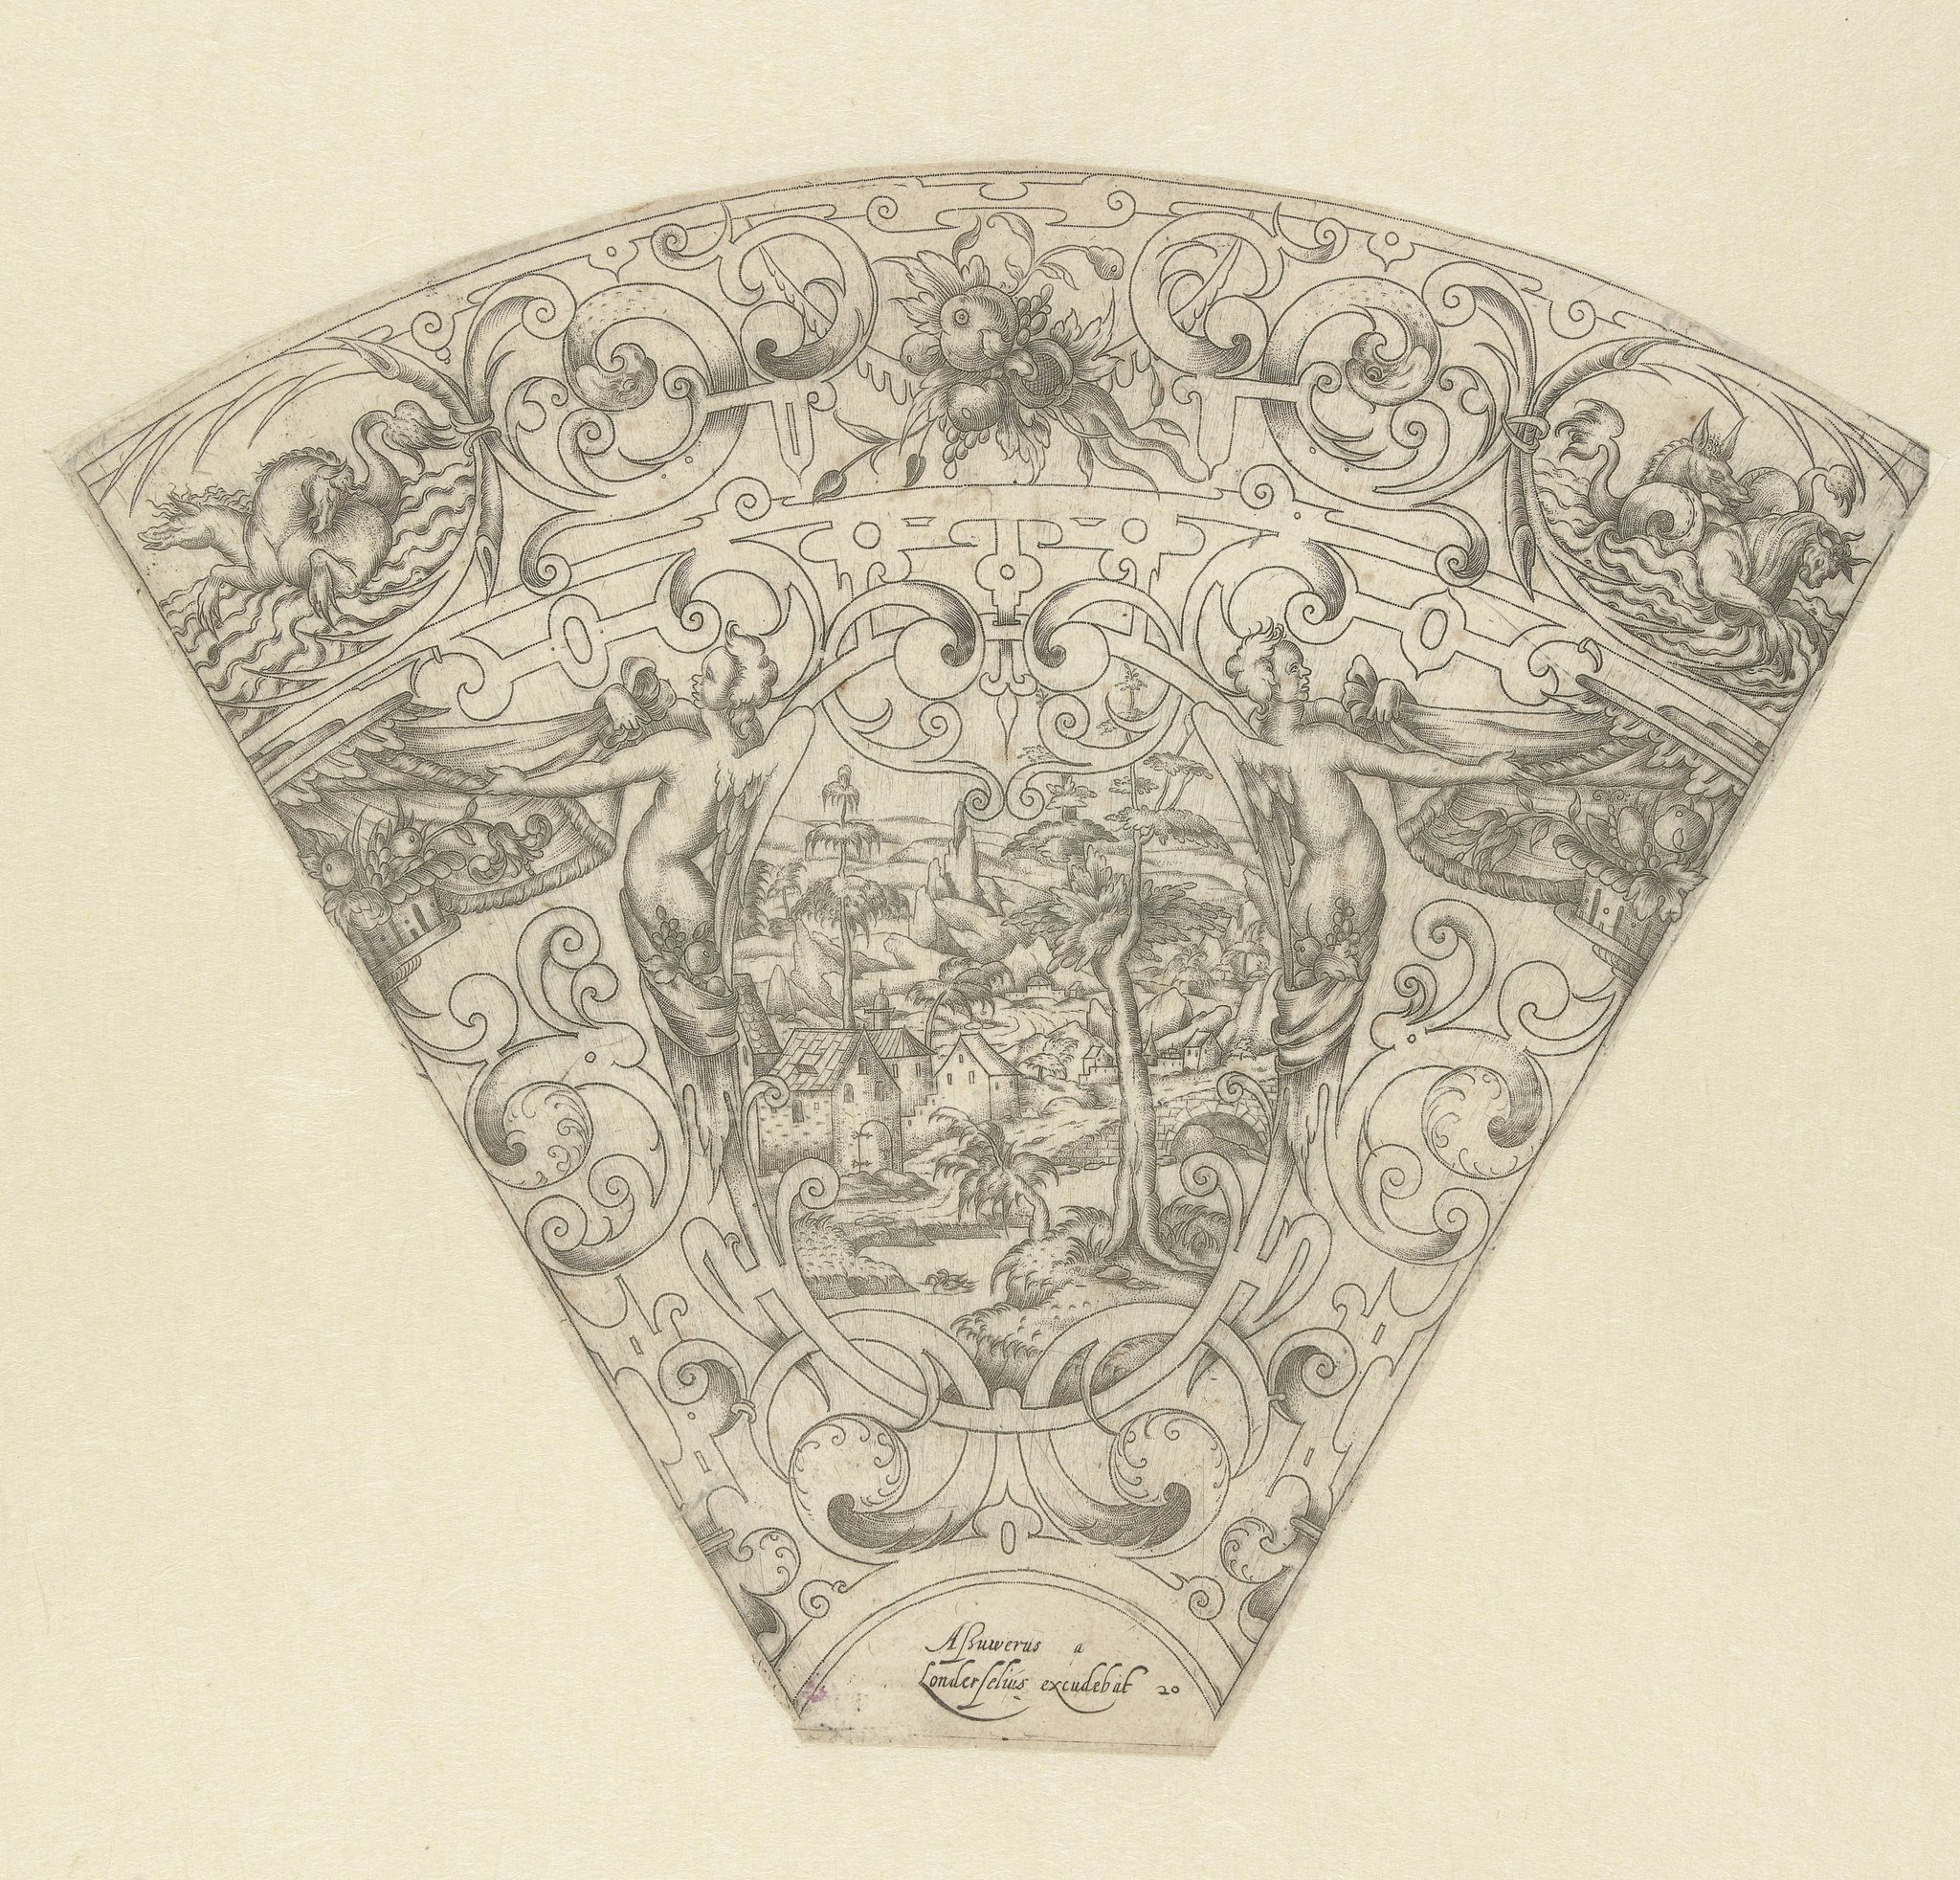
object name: ornament print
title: Waaiervormig segment met een landschap in een ovaal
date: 1594-1635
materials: paper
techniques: engraving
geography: germany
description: Ovaal tussen twee engelen. De rand bovenaan bevat twee kleine ovalen met zeepaarden. Tegenzijdige kopieën van de onder Orn Cat I-324.A vermelde serie. Titelblad en 14 deels genummerde bladen uit een serie van 25.